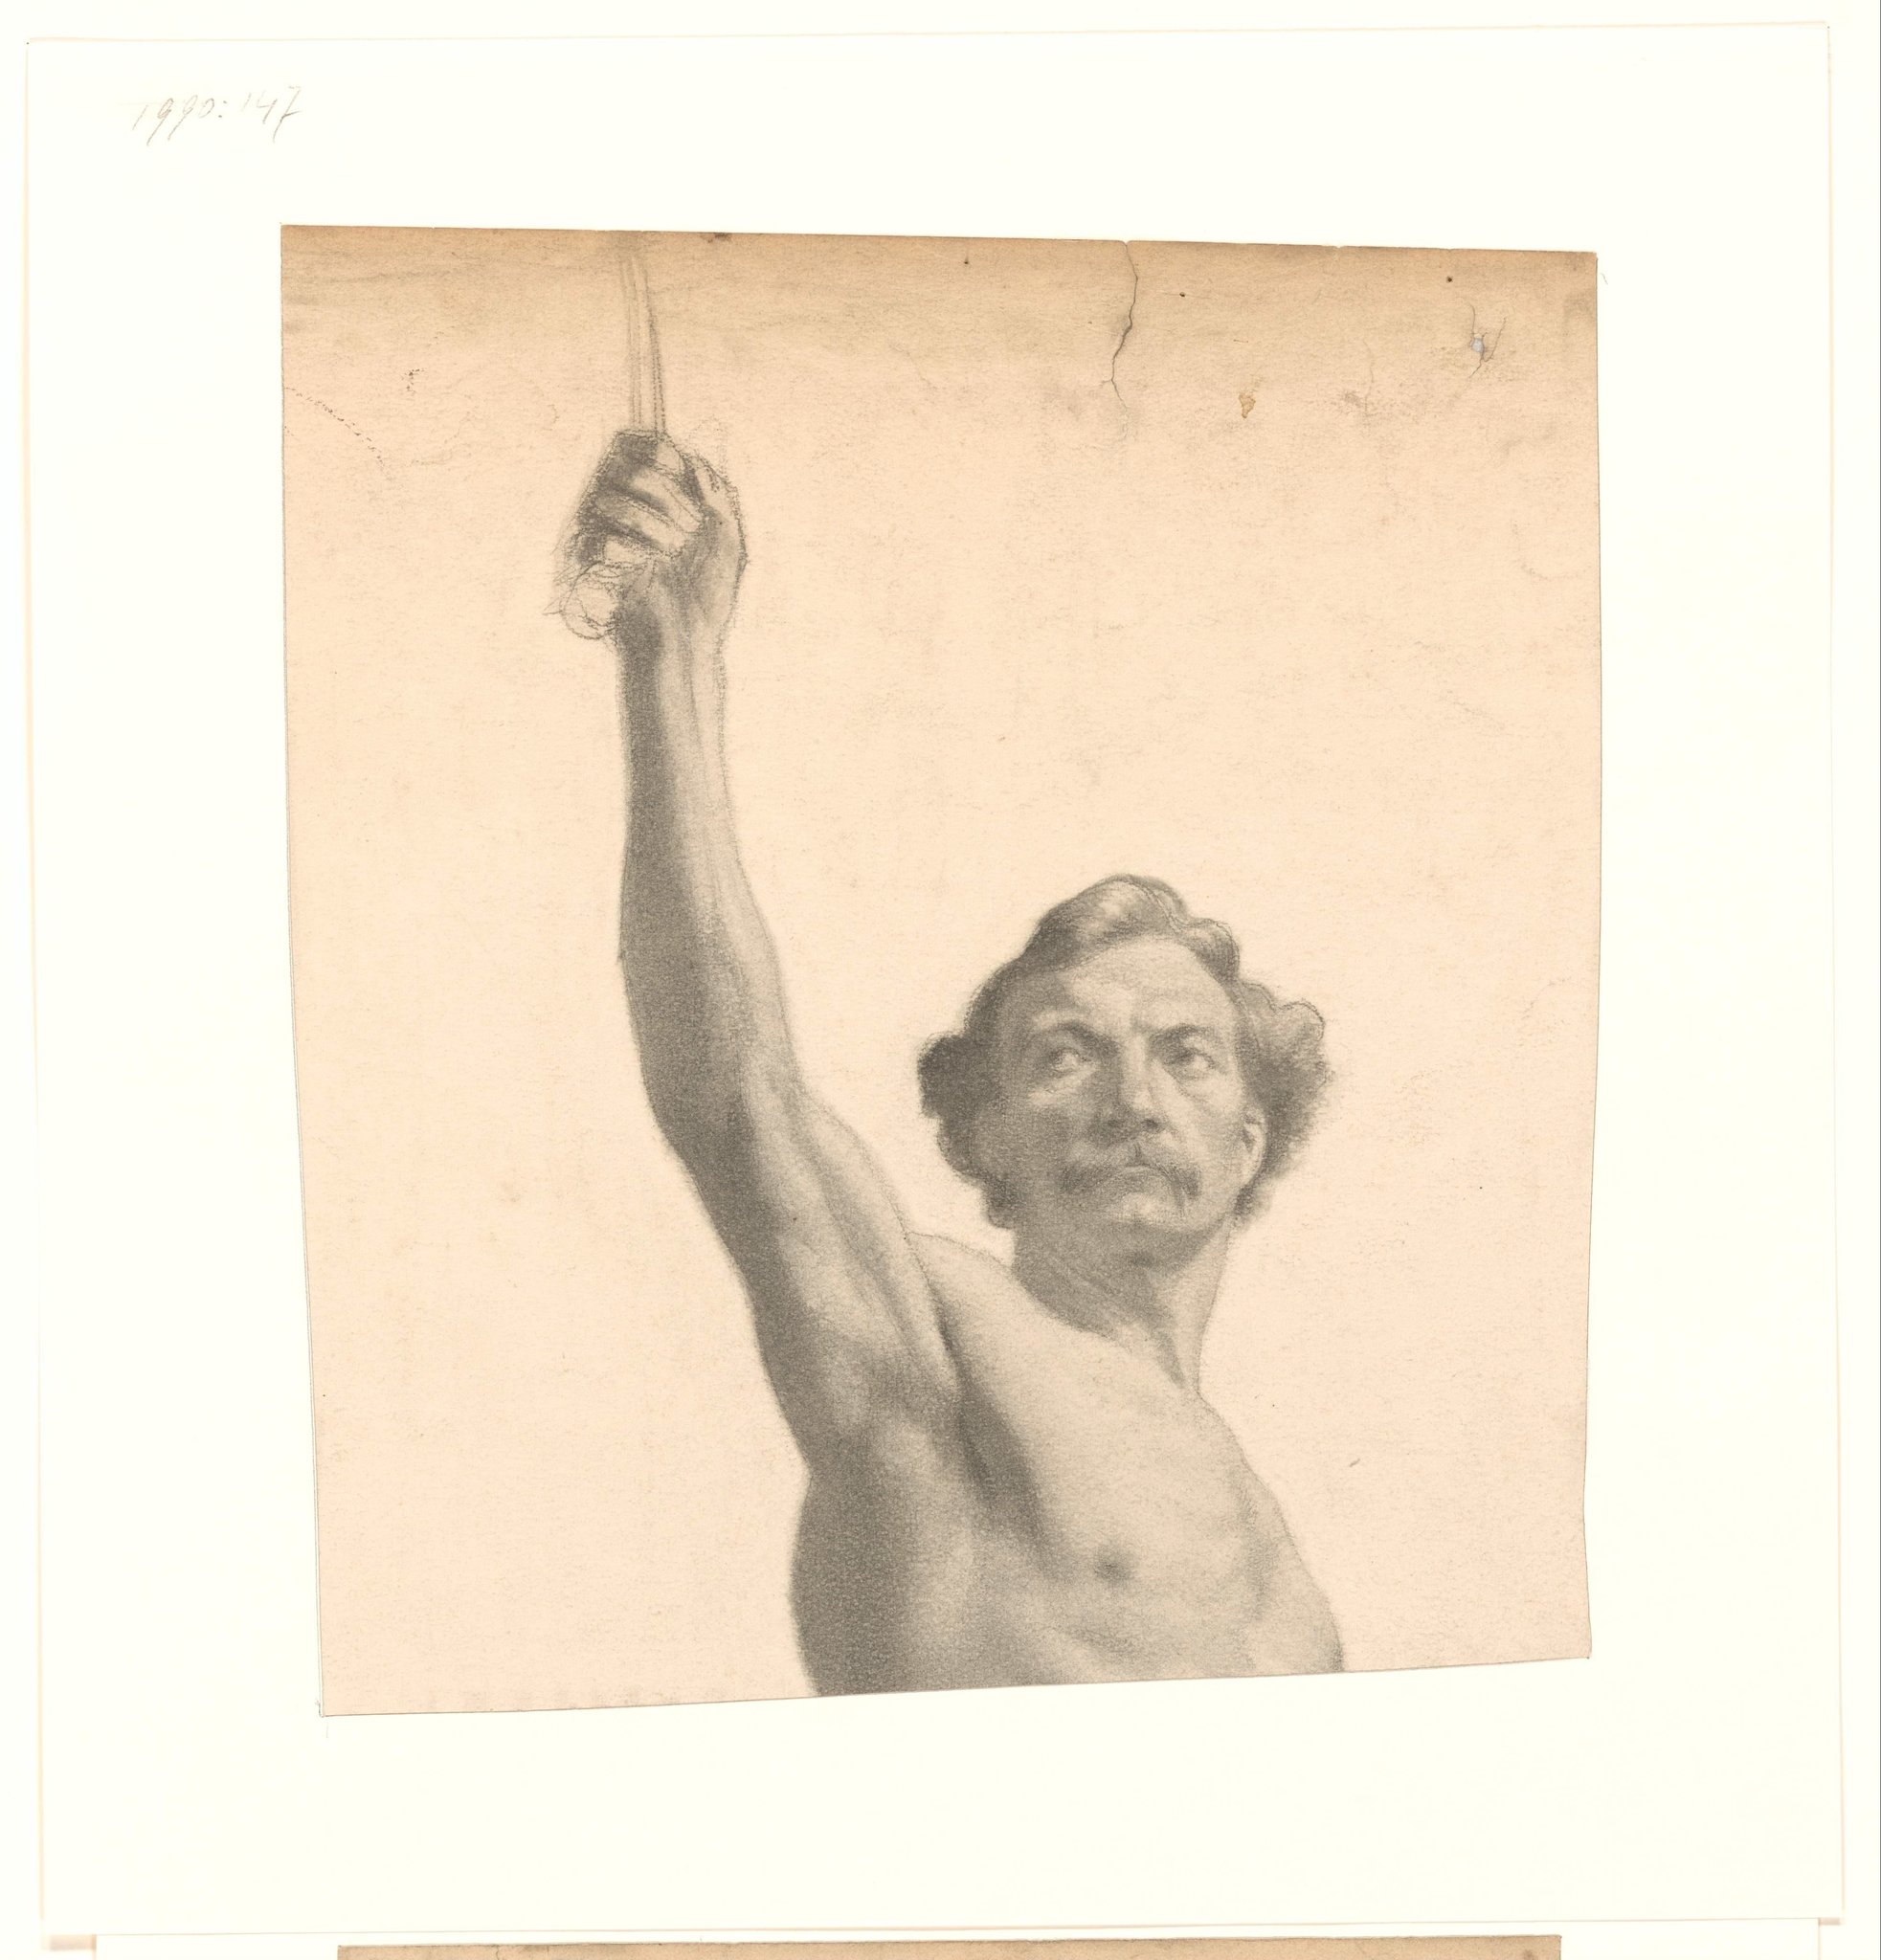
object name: drawing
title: Buste van mannelijk naakt met opgeheven rechterarm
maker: johan braakensiek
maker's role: draughtsman, print maker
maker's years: 1858-1940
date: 1868-1940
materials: chalk, paper